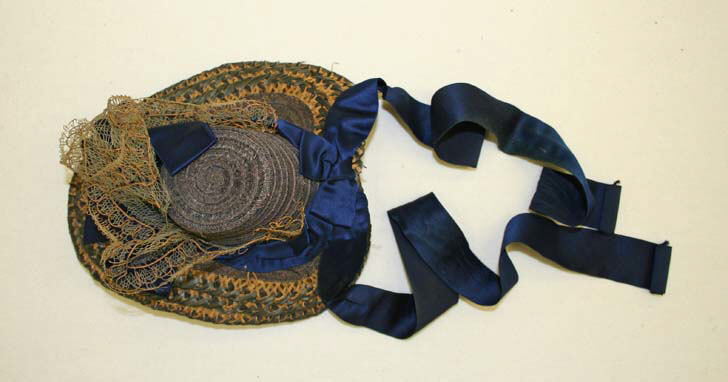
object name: hat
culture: american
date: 1880-1889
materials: fiber